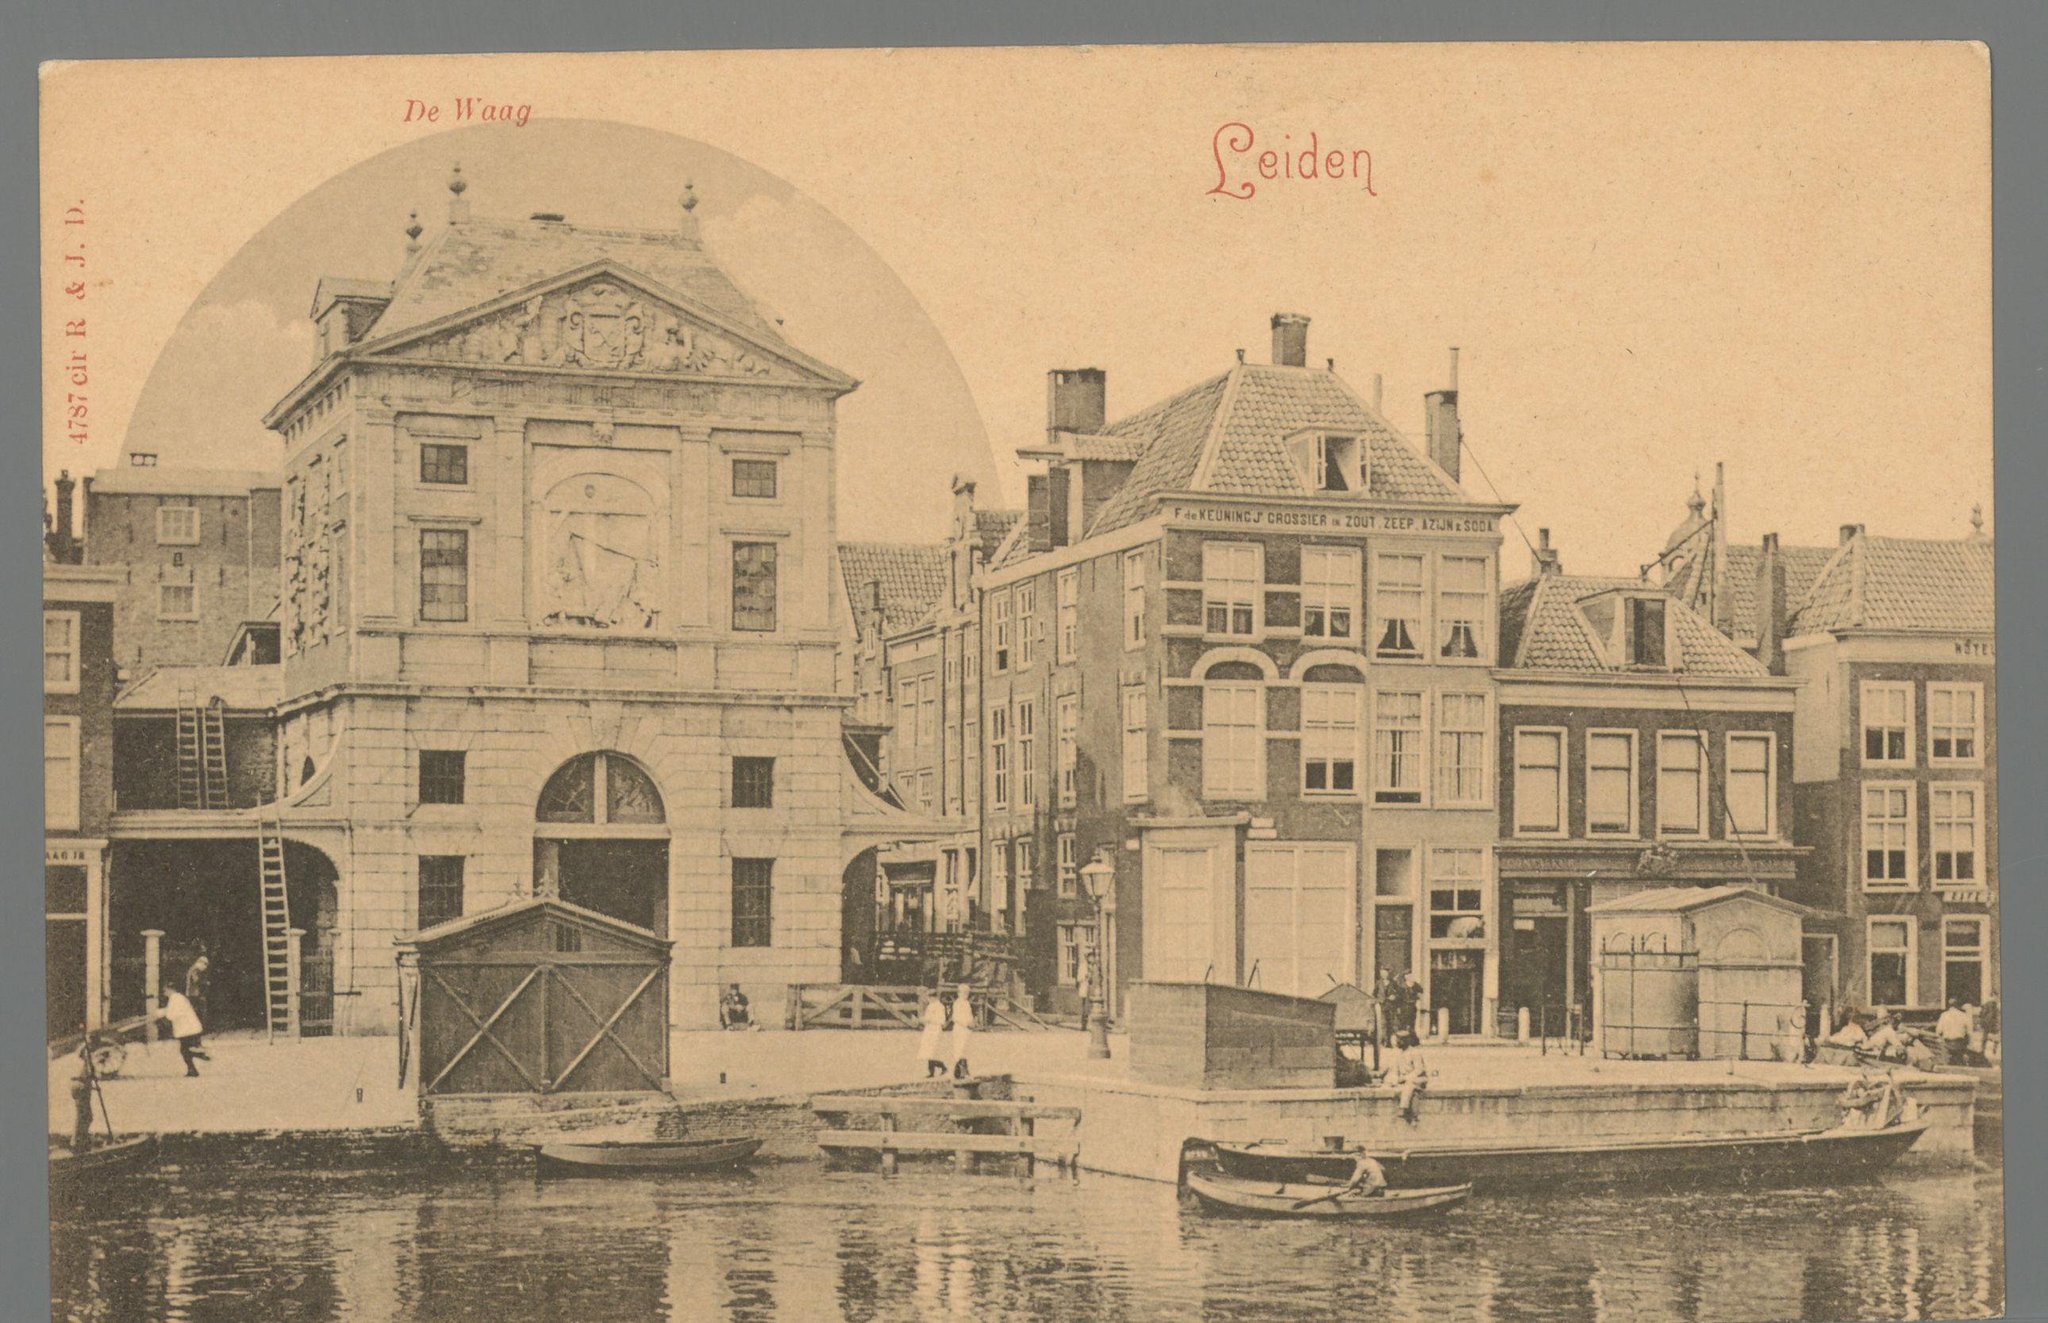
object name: ansichtkaart, prentbriefkaart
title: De Waag. Leiden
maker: Anonymous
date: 1892-1905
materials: cardboard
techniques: photograph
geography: leiden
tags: canal, street, weigh-house